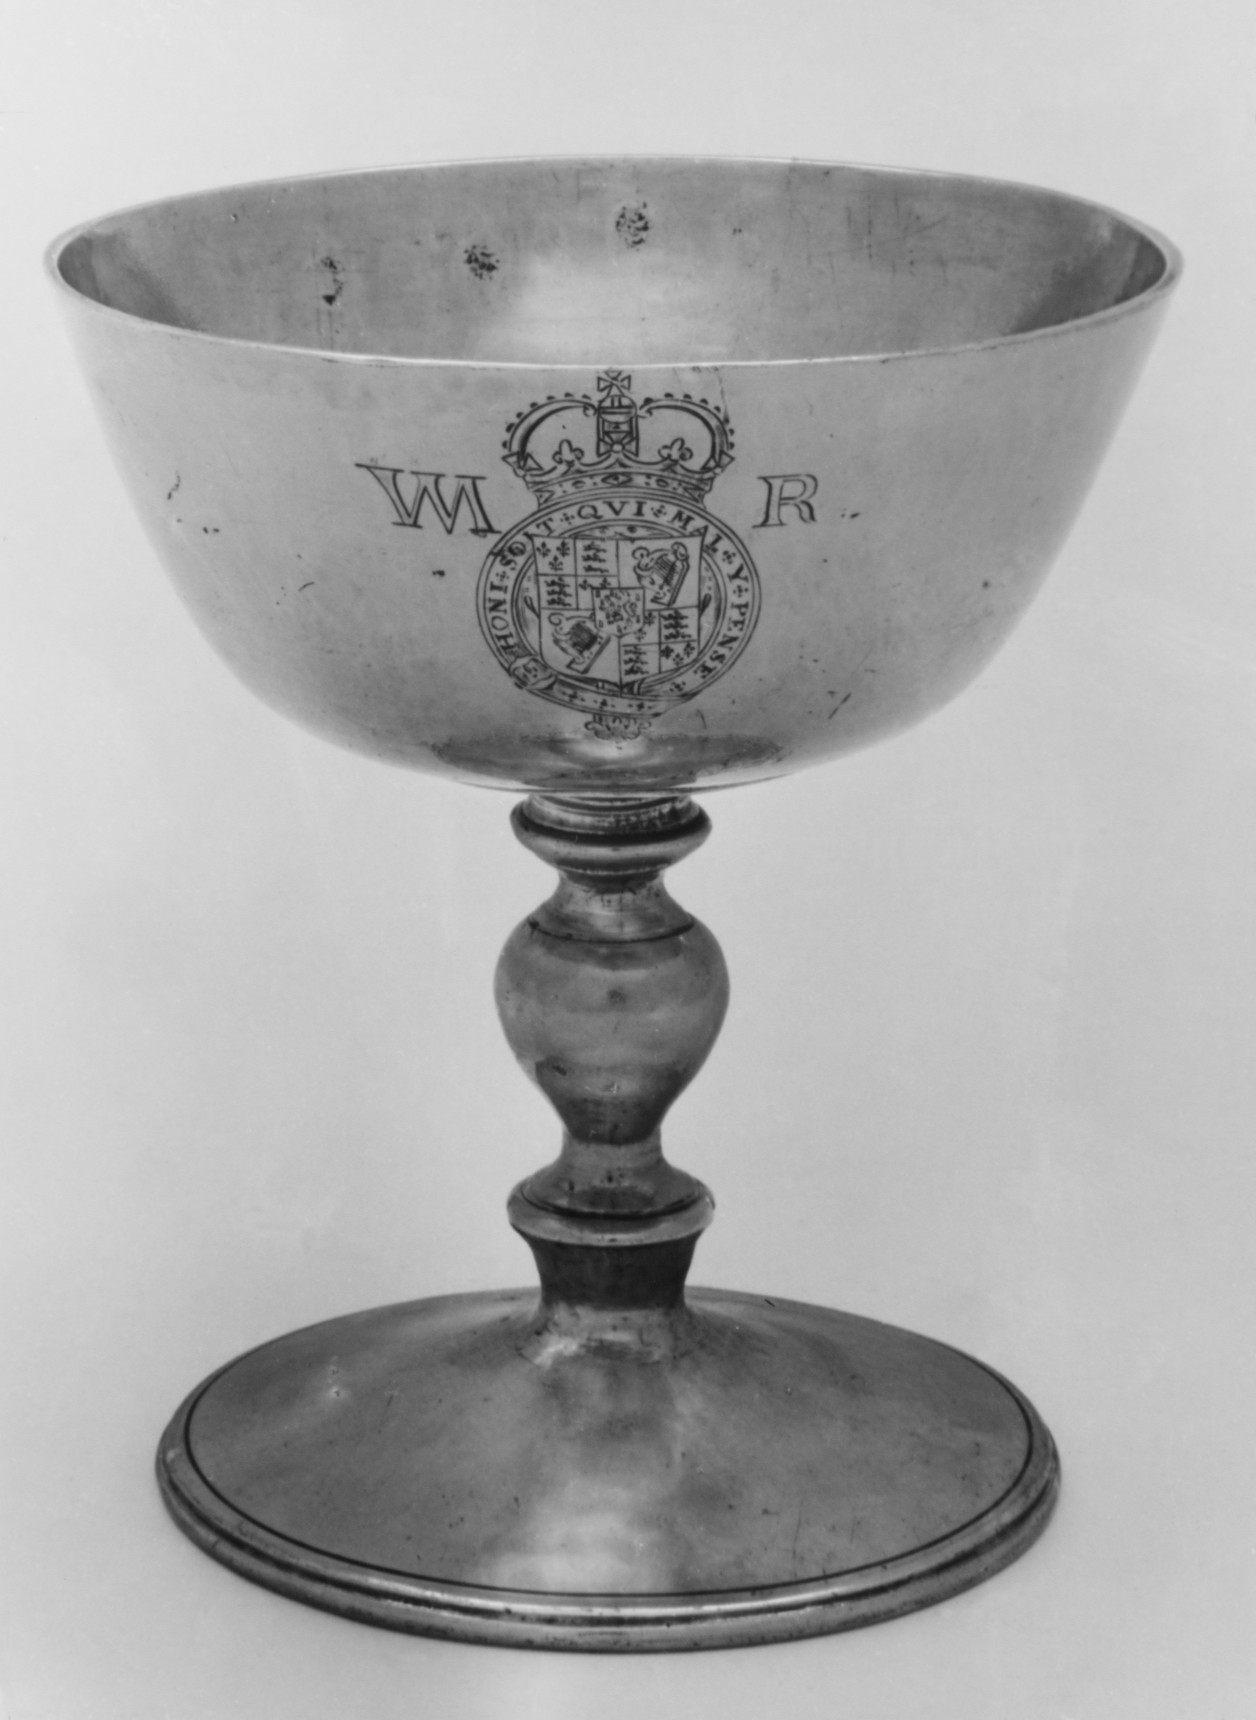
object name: communion cup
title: Communion cup (one of a pair)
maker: w. h., london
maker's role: maker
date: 1660-1661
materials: silver gilt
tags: coat of arms